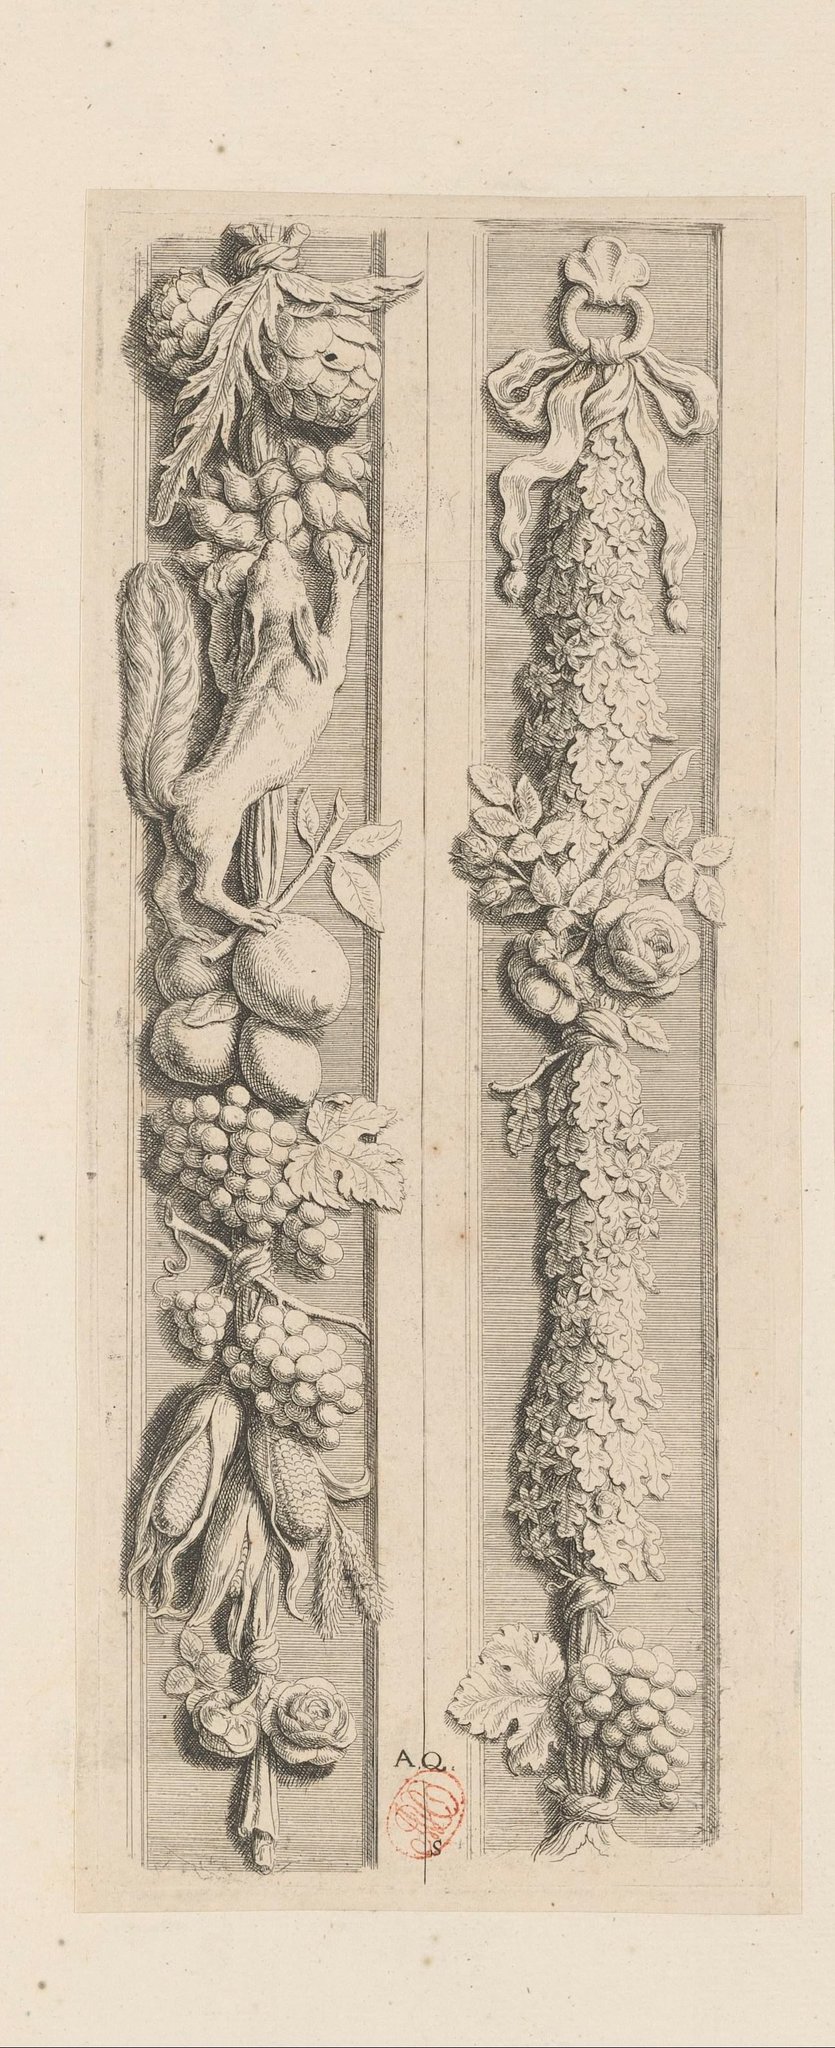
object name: book illustration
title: Pilasterfestoen met eekhoorn, fruit, bloemen, bladeren en maïs tussen galerij en Burgerzaal in het Stadhuis op de Dam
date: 1655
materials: paper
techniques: engraving, etching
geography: amsterdam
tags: fruits and vegetables ~ ornament, ornament ~ festoon, garland, rodents: squirrel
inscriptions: collector's mark: Lugt 195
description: Prent gebruikt in: Prima pars. Praecipuarum effigierum ac ornamentorum, amplissimae Curiae Amstelrodamensis (…) / Het eerste deel. Van de voornaemste Statuen ende Ciraten, vant konstijck Stadhuys van Amstelredam, tmeeste in marmer gemaeckt, door Artus Quellinus, Beelthouwer der voorseyde Stadt / La Premier Partie. De plusieurs Figures et ornements, de la Maison de Ville d'Amsterdam (…). Amsterdam: Artus Quellinus (I), 1655. Zie RP-P-AO-22-1-1 voor bijhorende titelpagina. Zie RP-P-AO-22-1-2 voor bijhorend register. Zie RP-P-AO-22-1A, RP-P-AO-22-1B, RP-P-AO-22-1C, RP-P-AO-22-1D-1, RP-P-AO-22-1D-2, RP-P-AO-22-1E, RP-P-AO-22-1F, RP-P-AO-22-1G, RP-P-AO-22-1H, RP-P-AO-22-1I, RP-P-AO-22-1K-1, RP-P-AO-22-1K-2, RP-P-AO-22-1K-3, RP-P-AO-22-1K-4, RP-P-AO-22-1K-5, RP-P-AO-22-1L-1, RP-P-AO-22-1L-2, RP-P-AO-22-1M-1, RP-P-AO-22-1M-2, RP-P-AO-22-1N-1, RP-P-AO-22-1N-2, RP-P-AO-22-1N-3, RP-P-AO-22-1N-4, RP-P-AO-22-1N-5, RP-P-AO-22-1O-1, RP-P-AO-22-1O-2, RP-P-AO-22-1O-3, RP-P-AO-22-1O-4, RP-P-AO-22-1P-1, RP-P-AO-22-1P-2, RP-P-AO-22-1P-3, RP-P-AO-22-1P-4, RP-P-AO-22-1Q-1, RP-P-AO-22-1Q-2, RP-P-AO-22-1Q-3, RP-P-AO-22-1Q-4, RP-P-AO-22-1R-1, RP-P-AO-22-1R-2, RP-P-AO-22-1R-3, RP-P-AO-22-1R-4, RP-P-AO-22-1R-5, RP-P-AO-22-1S-1, RP-P-AO-22-1S-2, RP-P-AO-22-1S-4, RP-P-AO-22-1S-5, RP-P-AO-22-1T-1 en RP-P-AO-22-1T-2 voor andere prenten uit deze publicatie. Zelfde staat van prent ook gebruikt in: Prima pars. Praecipuarum effigierum ac ornamentorum, amplissimae Curiae Amstelrodamensis (…) / Het eerste deel. Van de voornaemste Statuen ende Ciraten, vant konstijck Stadhuys van Amstelredam, tmeeste in marmer gemaeckt, door Artus Quellinus, Beelthouwer der voorseyde Stadt / La Premier Partie. De plusieurs Figures et ornements, de la Maison de Ville d'Amsterdam (…). Amsterdam: Frederik de Wit, 1665. Latere staat van prent ook gebruikt in: Architecture peinture et sculpture de la Maison de Ville d'Amsterdam, representee en CIX. figures en taille-douce (…). Amsterdam: David Mortier, 1719. En in: Architecture peinture et sculpture de la Maison de Ville d'Amsterdam, representee en CIX. figures en taille-douce (…). Amsterdam: Gerard Valck, 1719. En in: Bouw schilder en beeldhouwkonst, van het Stadhuis te Amsteldam, vertoont in CIX figuuren (…). Amsterdam: Covens & Mortier & Covens Jr., s.a. (1774-1783).